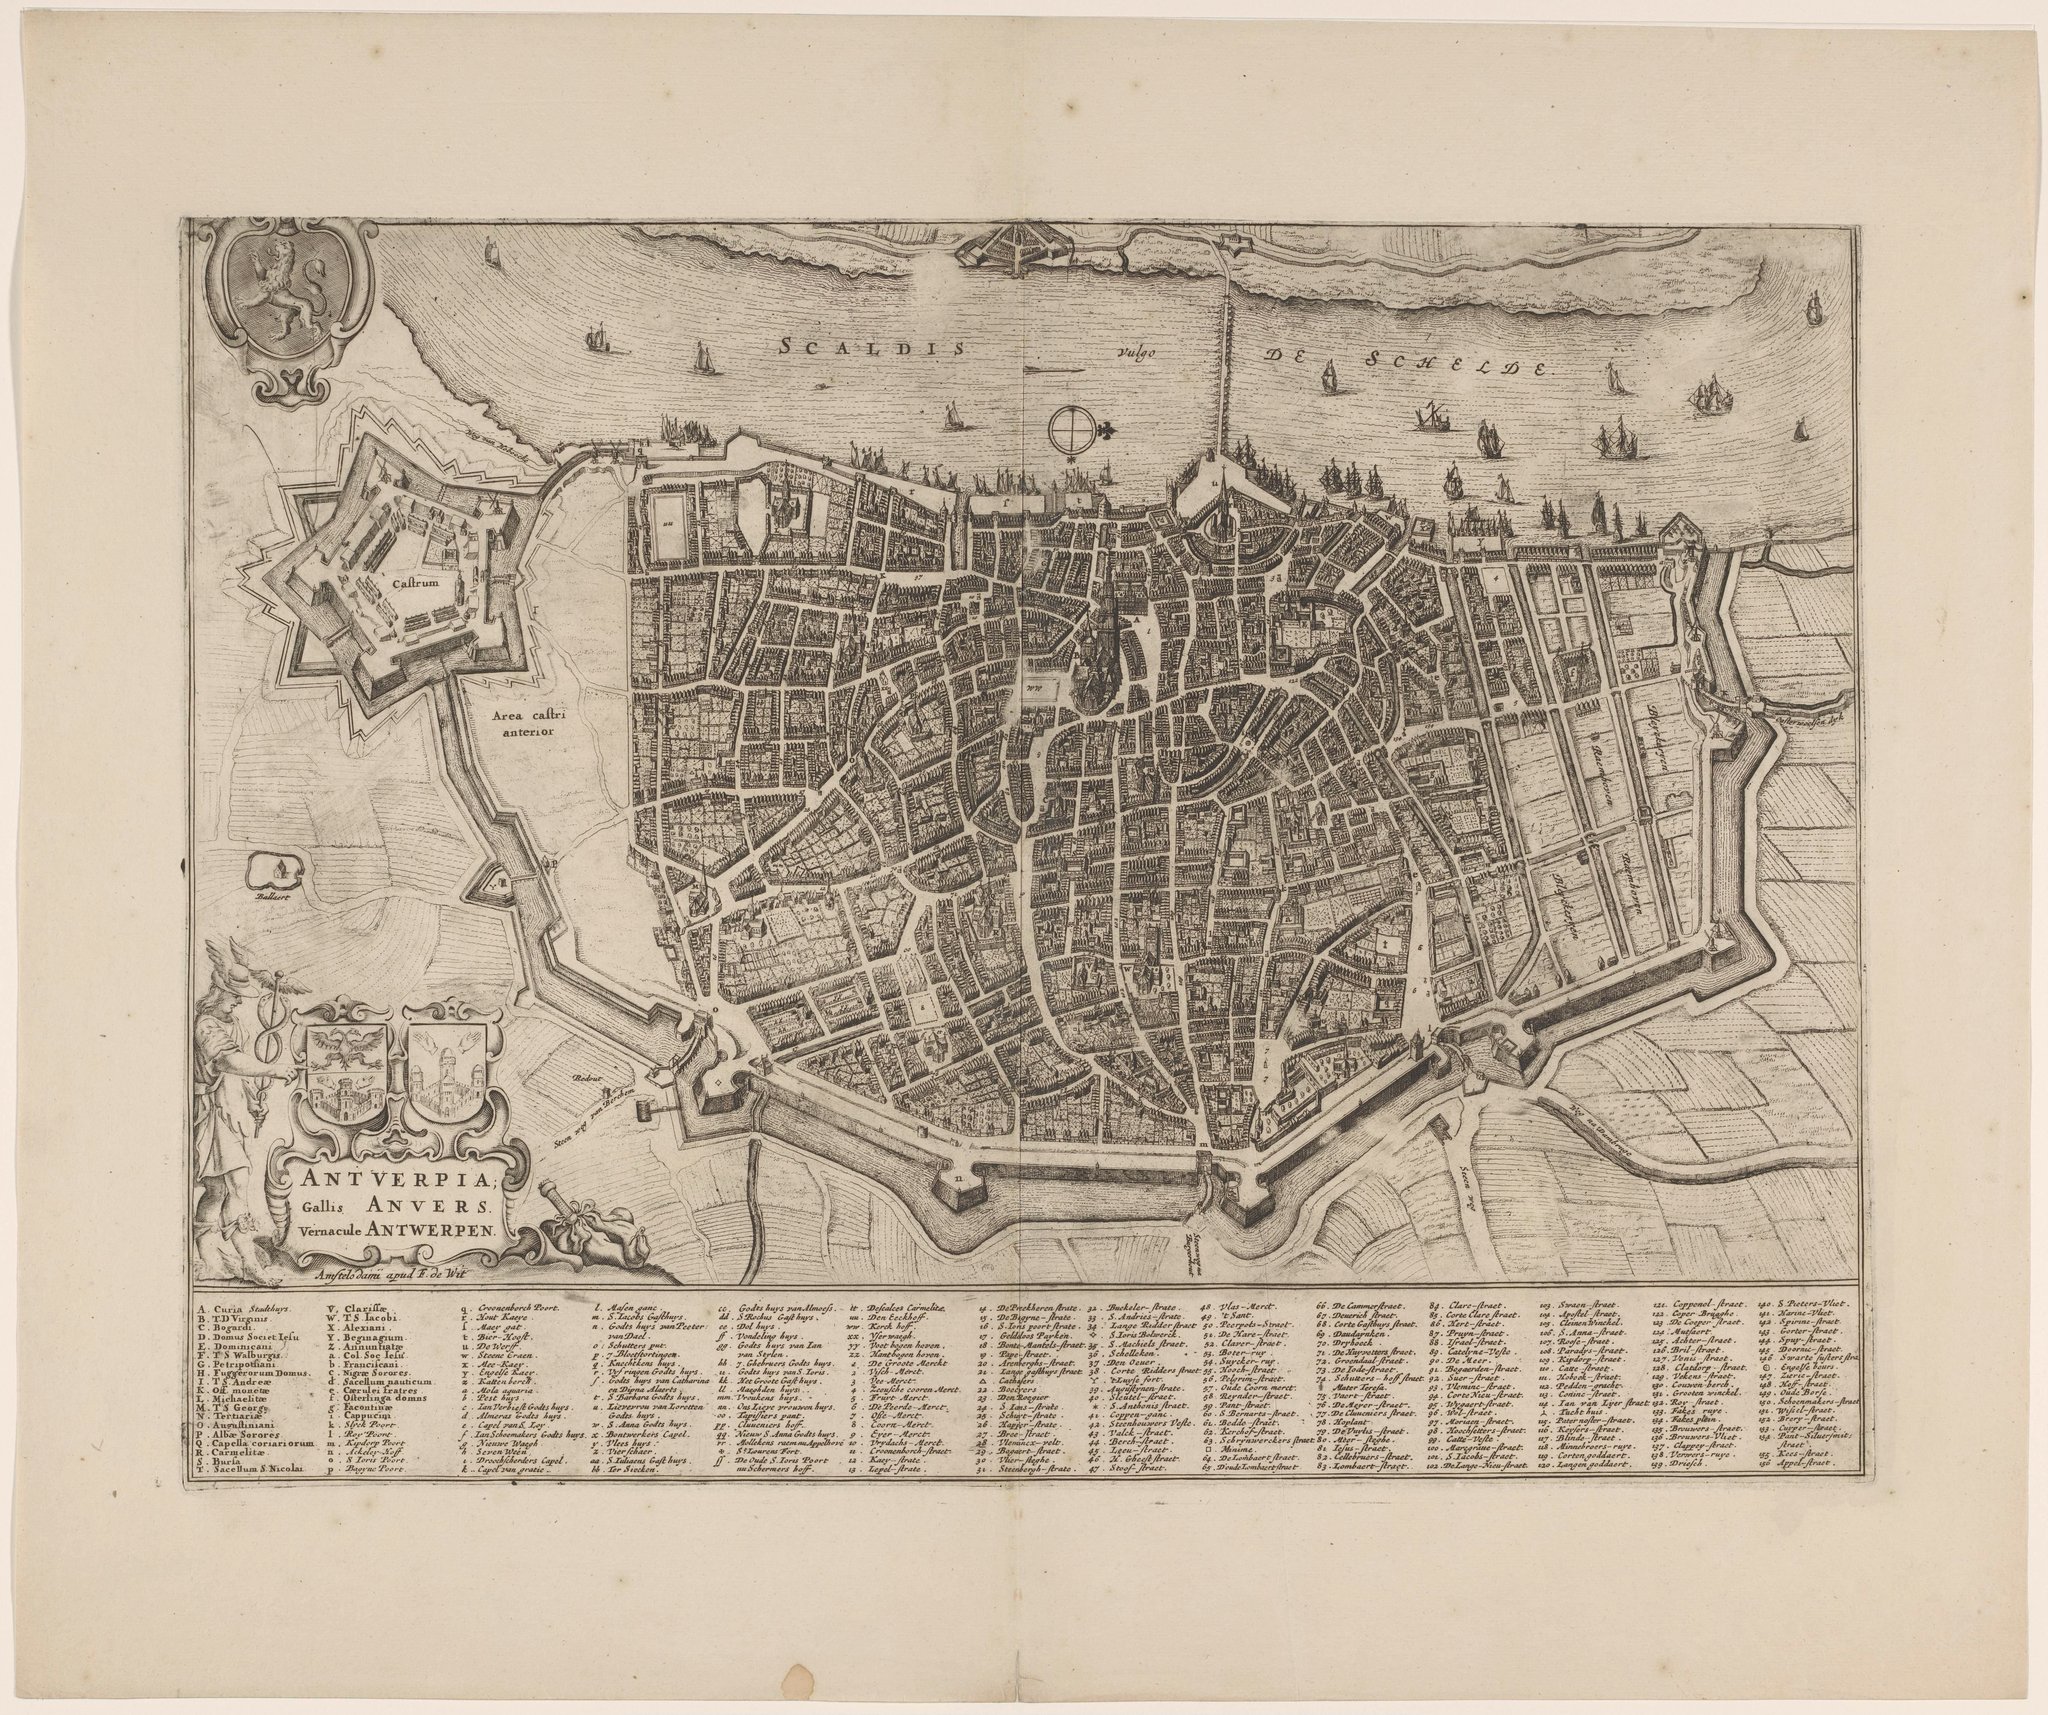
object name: print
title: Antverpia; Gallis Anvers vernacule Antwerpen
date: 1694-1706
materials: paper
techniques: engraving, etching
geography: amsterdam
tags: coat of arms (as symbol of the state, etc.) (+ city; municipal), (story of) mercury (hermes), fortified city, maps of cities, coat of arms (as symbol of the state, etc.) (+ province; provincial), antwerp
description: Plattegrond van Antwerpen met gebouwen in vogelvluchtperspectief. Linksonder de titelcartouche met links het wapen van Antwerpen en rechts van de stad Antwerpen. Linksboven het wapen van Brabant. In een balk onder de kaart een legenda A-Z, a-z, aa-zz en 1-156.